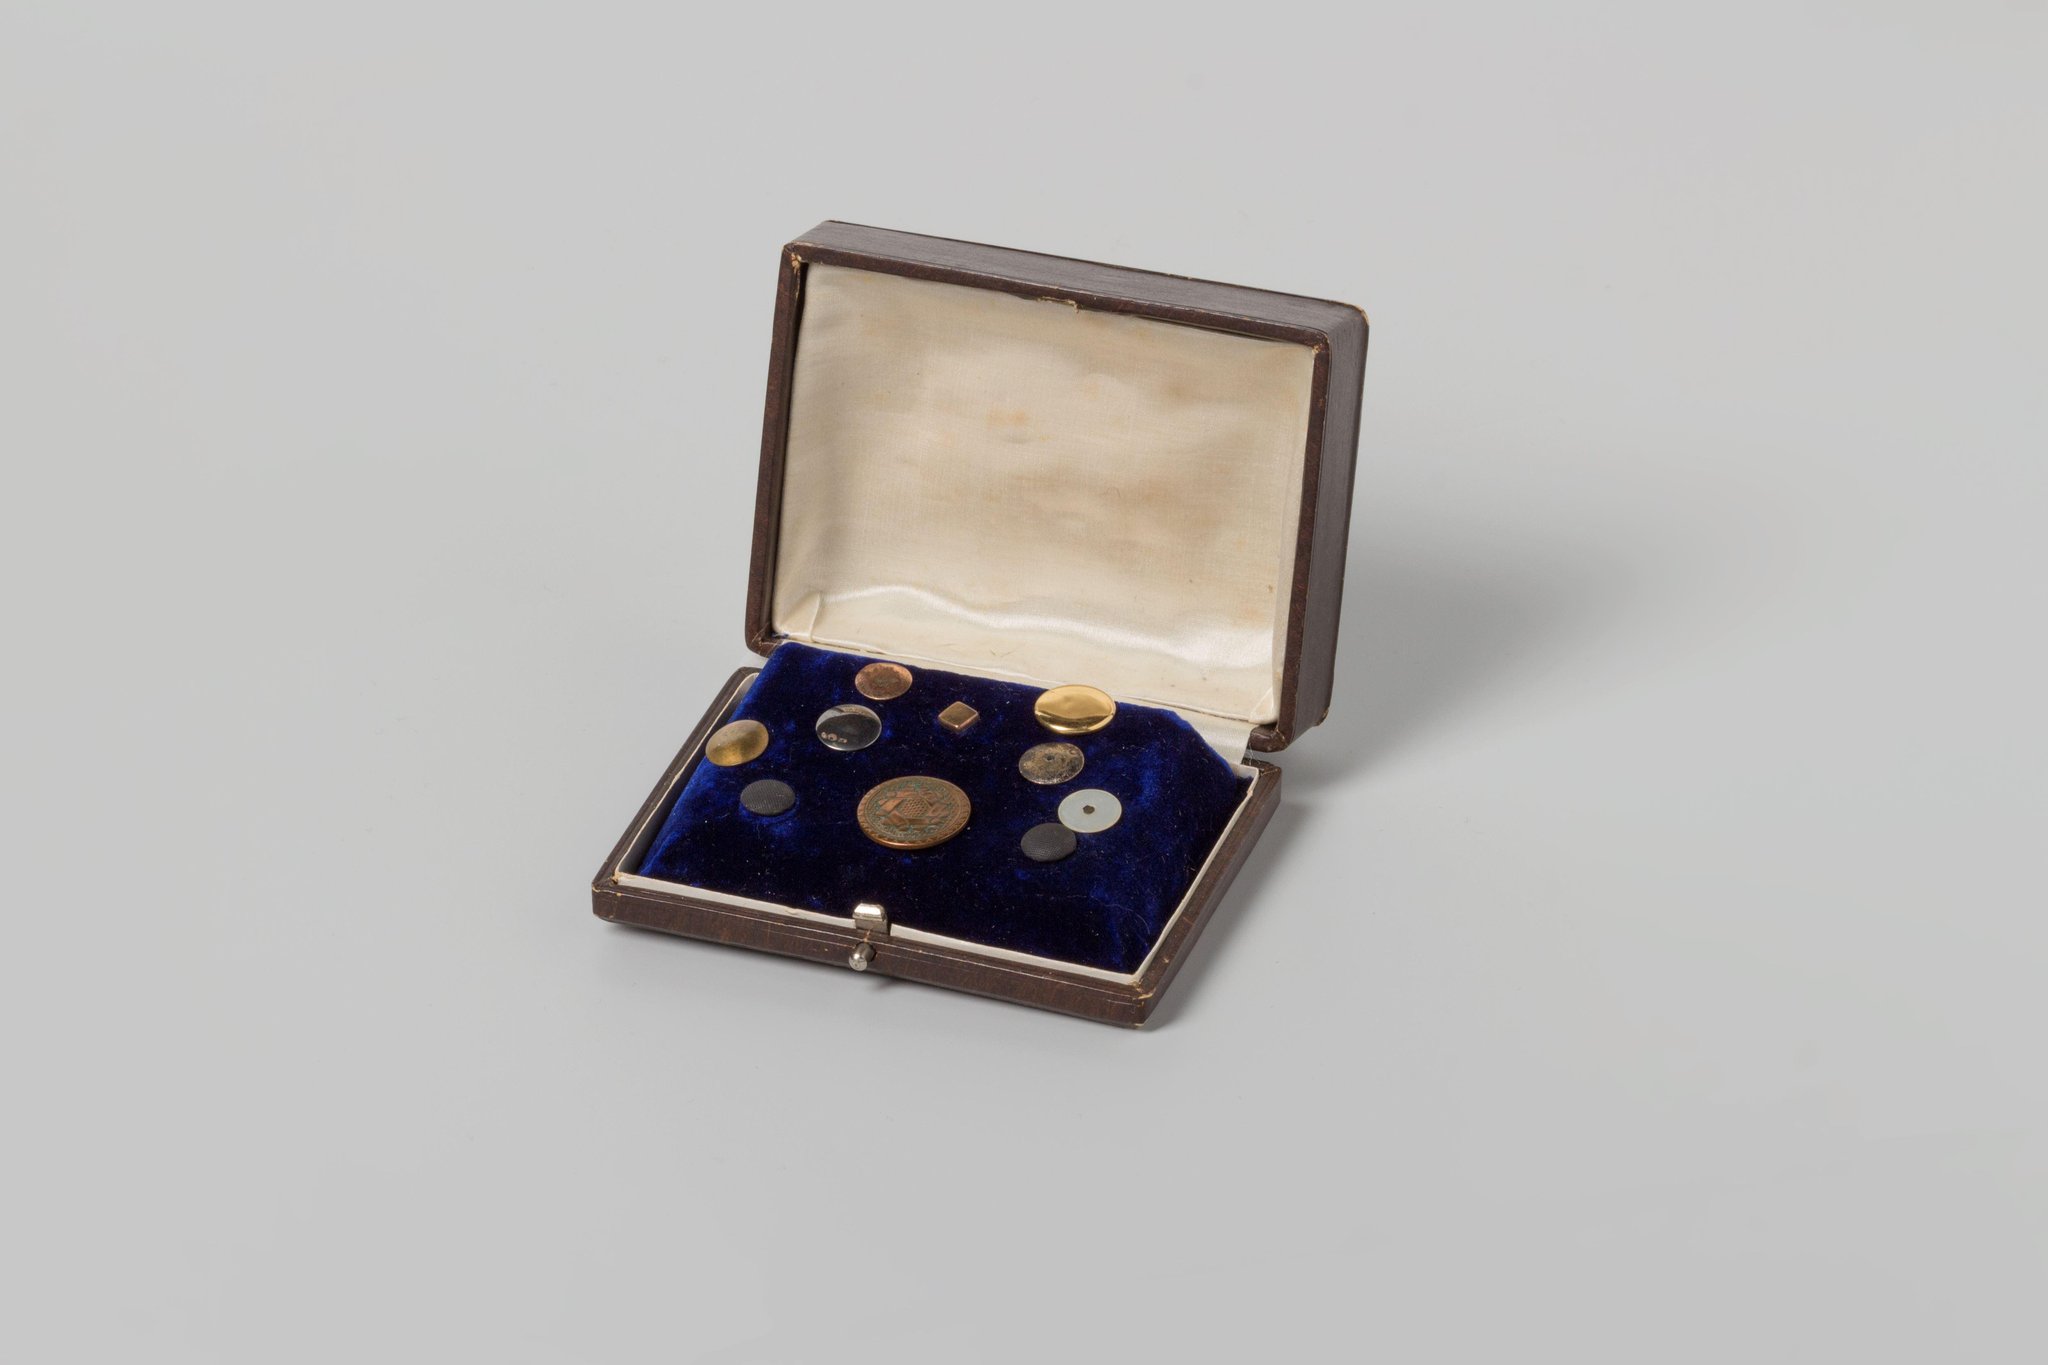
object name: collar button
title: Ronde vestknoop of boordeknoop van zilver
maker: Anonymous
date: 1900-1925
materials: silver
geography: western europe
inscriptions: mark, mark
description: Verzameling herenknoopen in zwart doosje. In niello zilver.